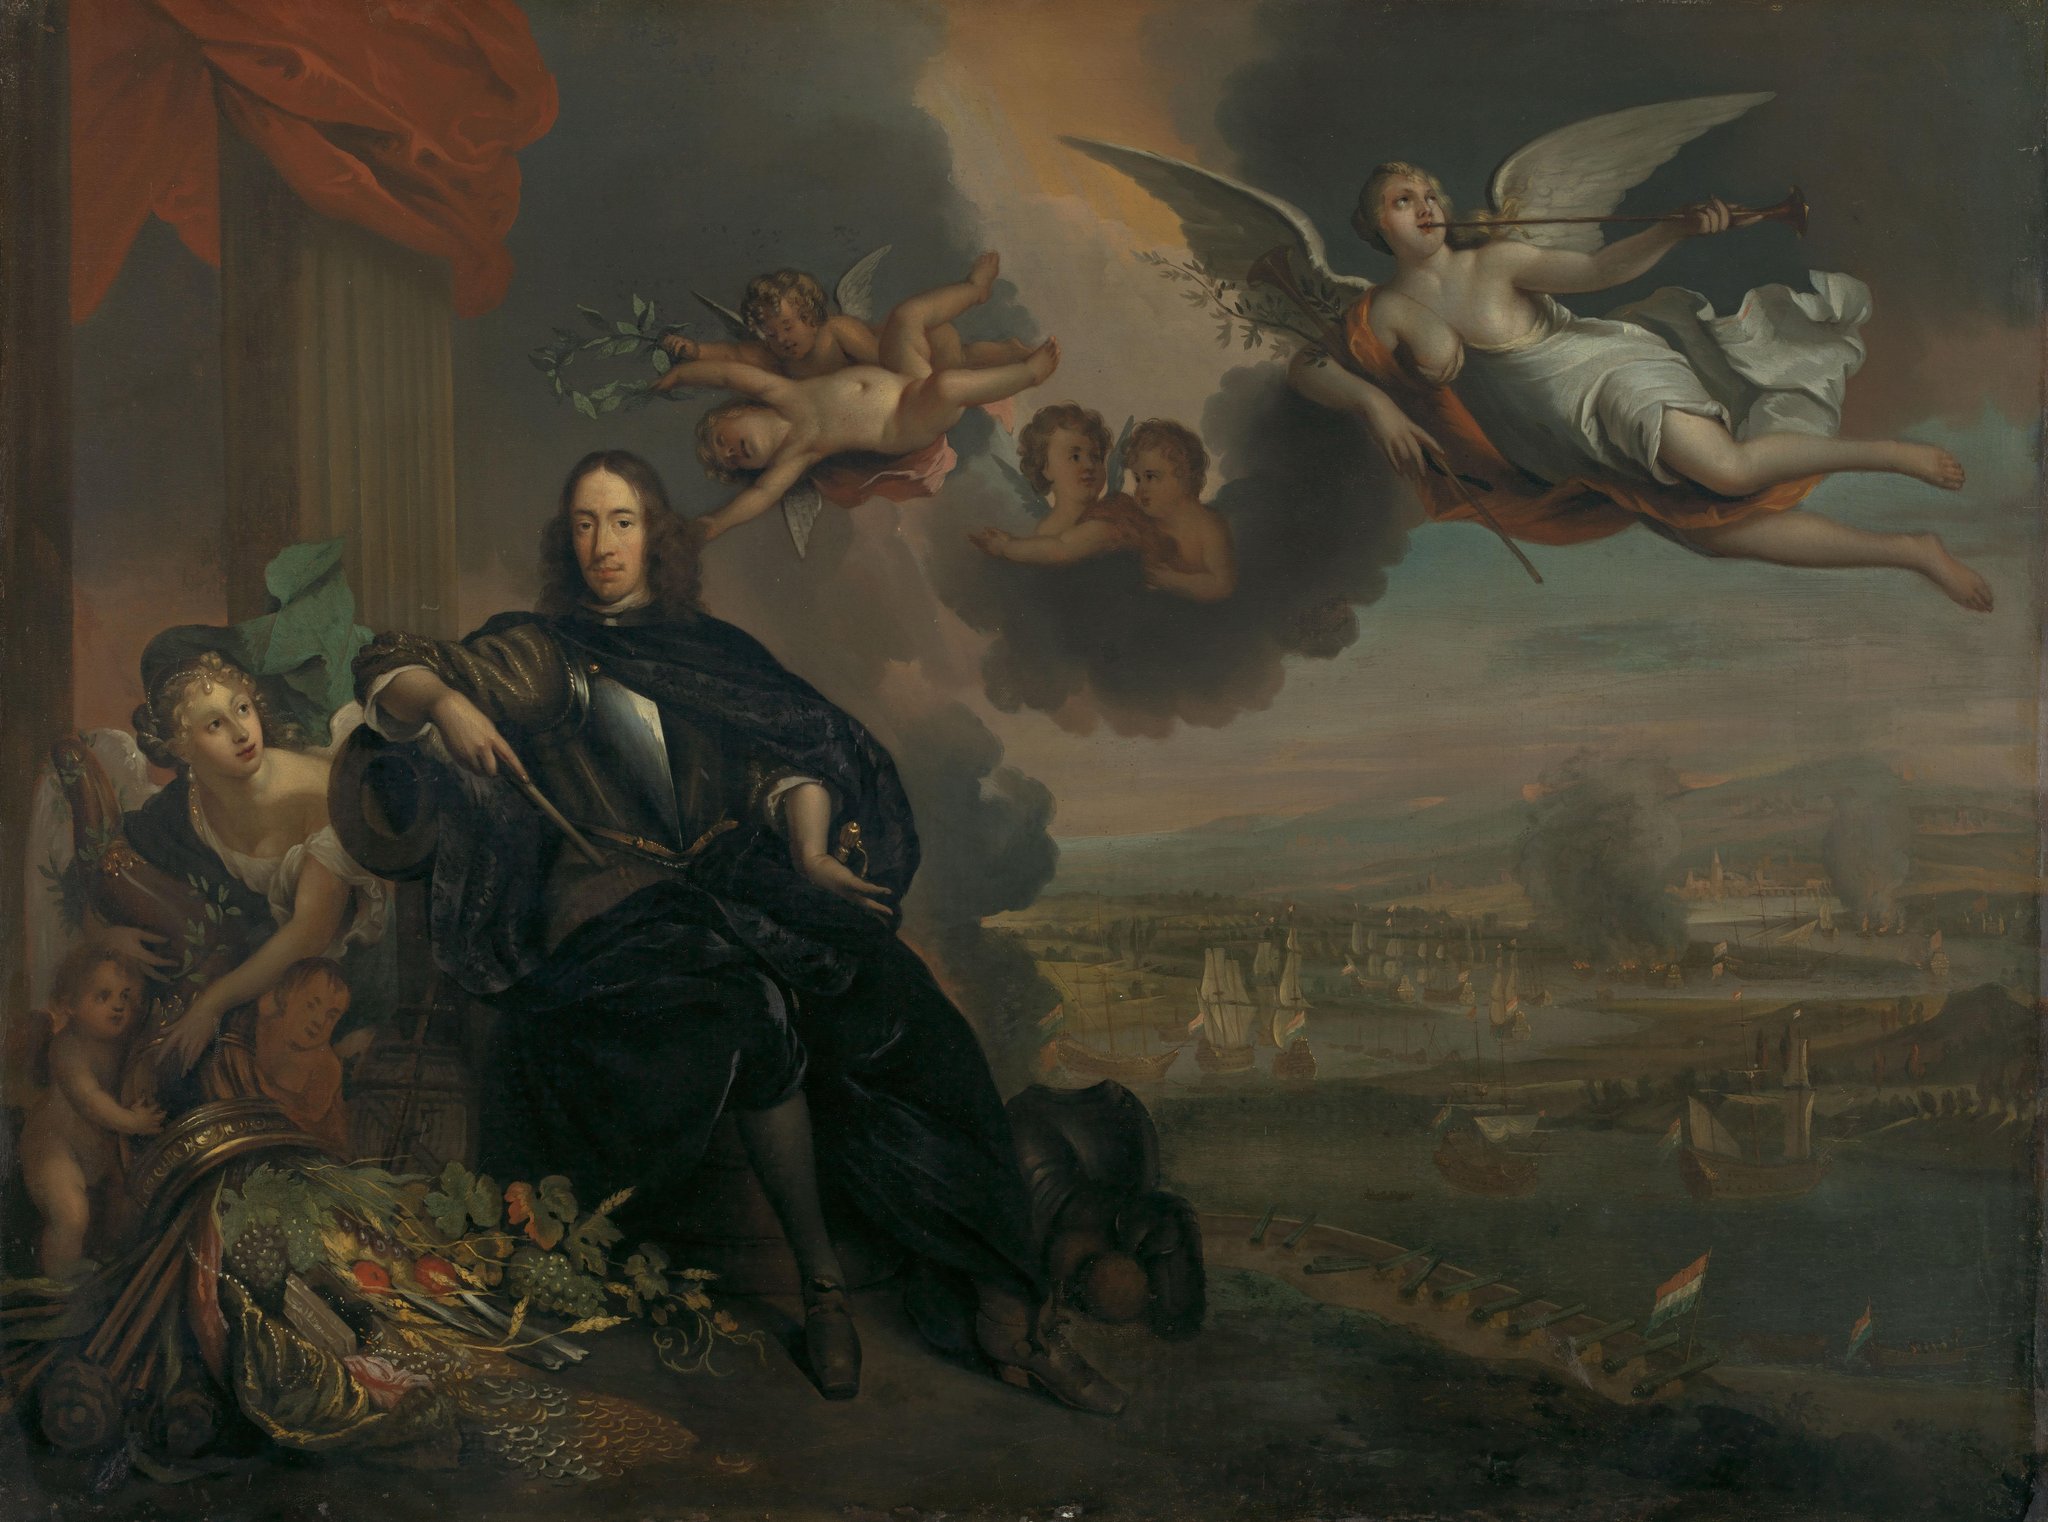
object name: painting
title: The Apotheosis of Cornelis de Witt, with the Dutch Raid on the Medway in the background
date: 1667-1700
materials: canvas, oil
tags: dordrecht, cornelis de witt, raid on the medway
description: The apotheosis of Cornelis de Witt, by J. de Baen, c. 1668. Cornelis de Witt (1623-1672) sailed with the Dutch fleet that attacked the English naval base at Chatham in June 1667 as representative of the States General. The artist has depicted the successful action in the background. In the foreground, De Witt is portrayed in fictitious dress. He is surrounded by attributes associated with war, such as a cannon and a suit of armour. To the right, a horn of plenty spills out at Cornelis's feet. An angel holds a victory wreath over his head, while Fame, floating above, sounds her trumpet. The frame is decorated with all kinds of weapons. Above: the arms of the city of Dordrecht, where Cornelis was burgomaster. Bottom: the coat of arms of the De Witt family. The painting is a replica of a larger work that originally hung in Dordrecht town hall. It was destroyed in 1672.